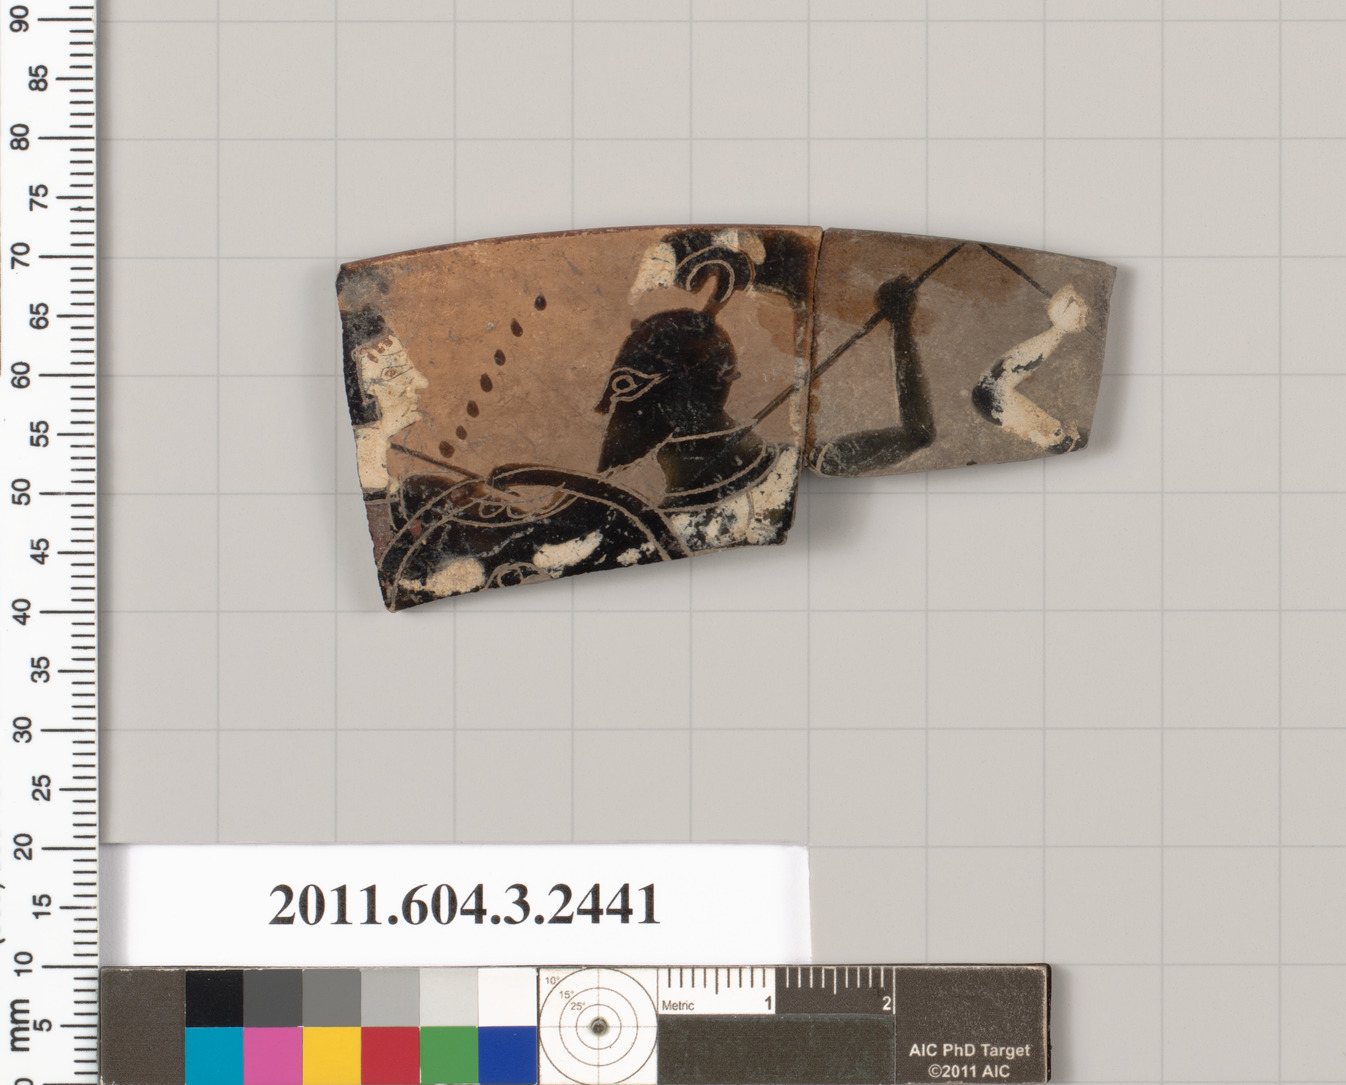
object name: kylix fragment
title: Terracotta rim fragment of a kylix (drinking cup)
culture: greek, attic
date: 525-501 BCE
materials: terracotta